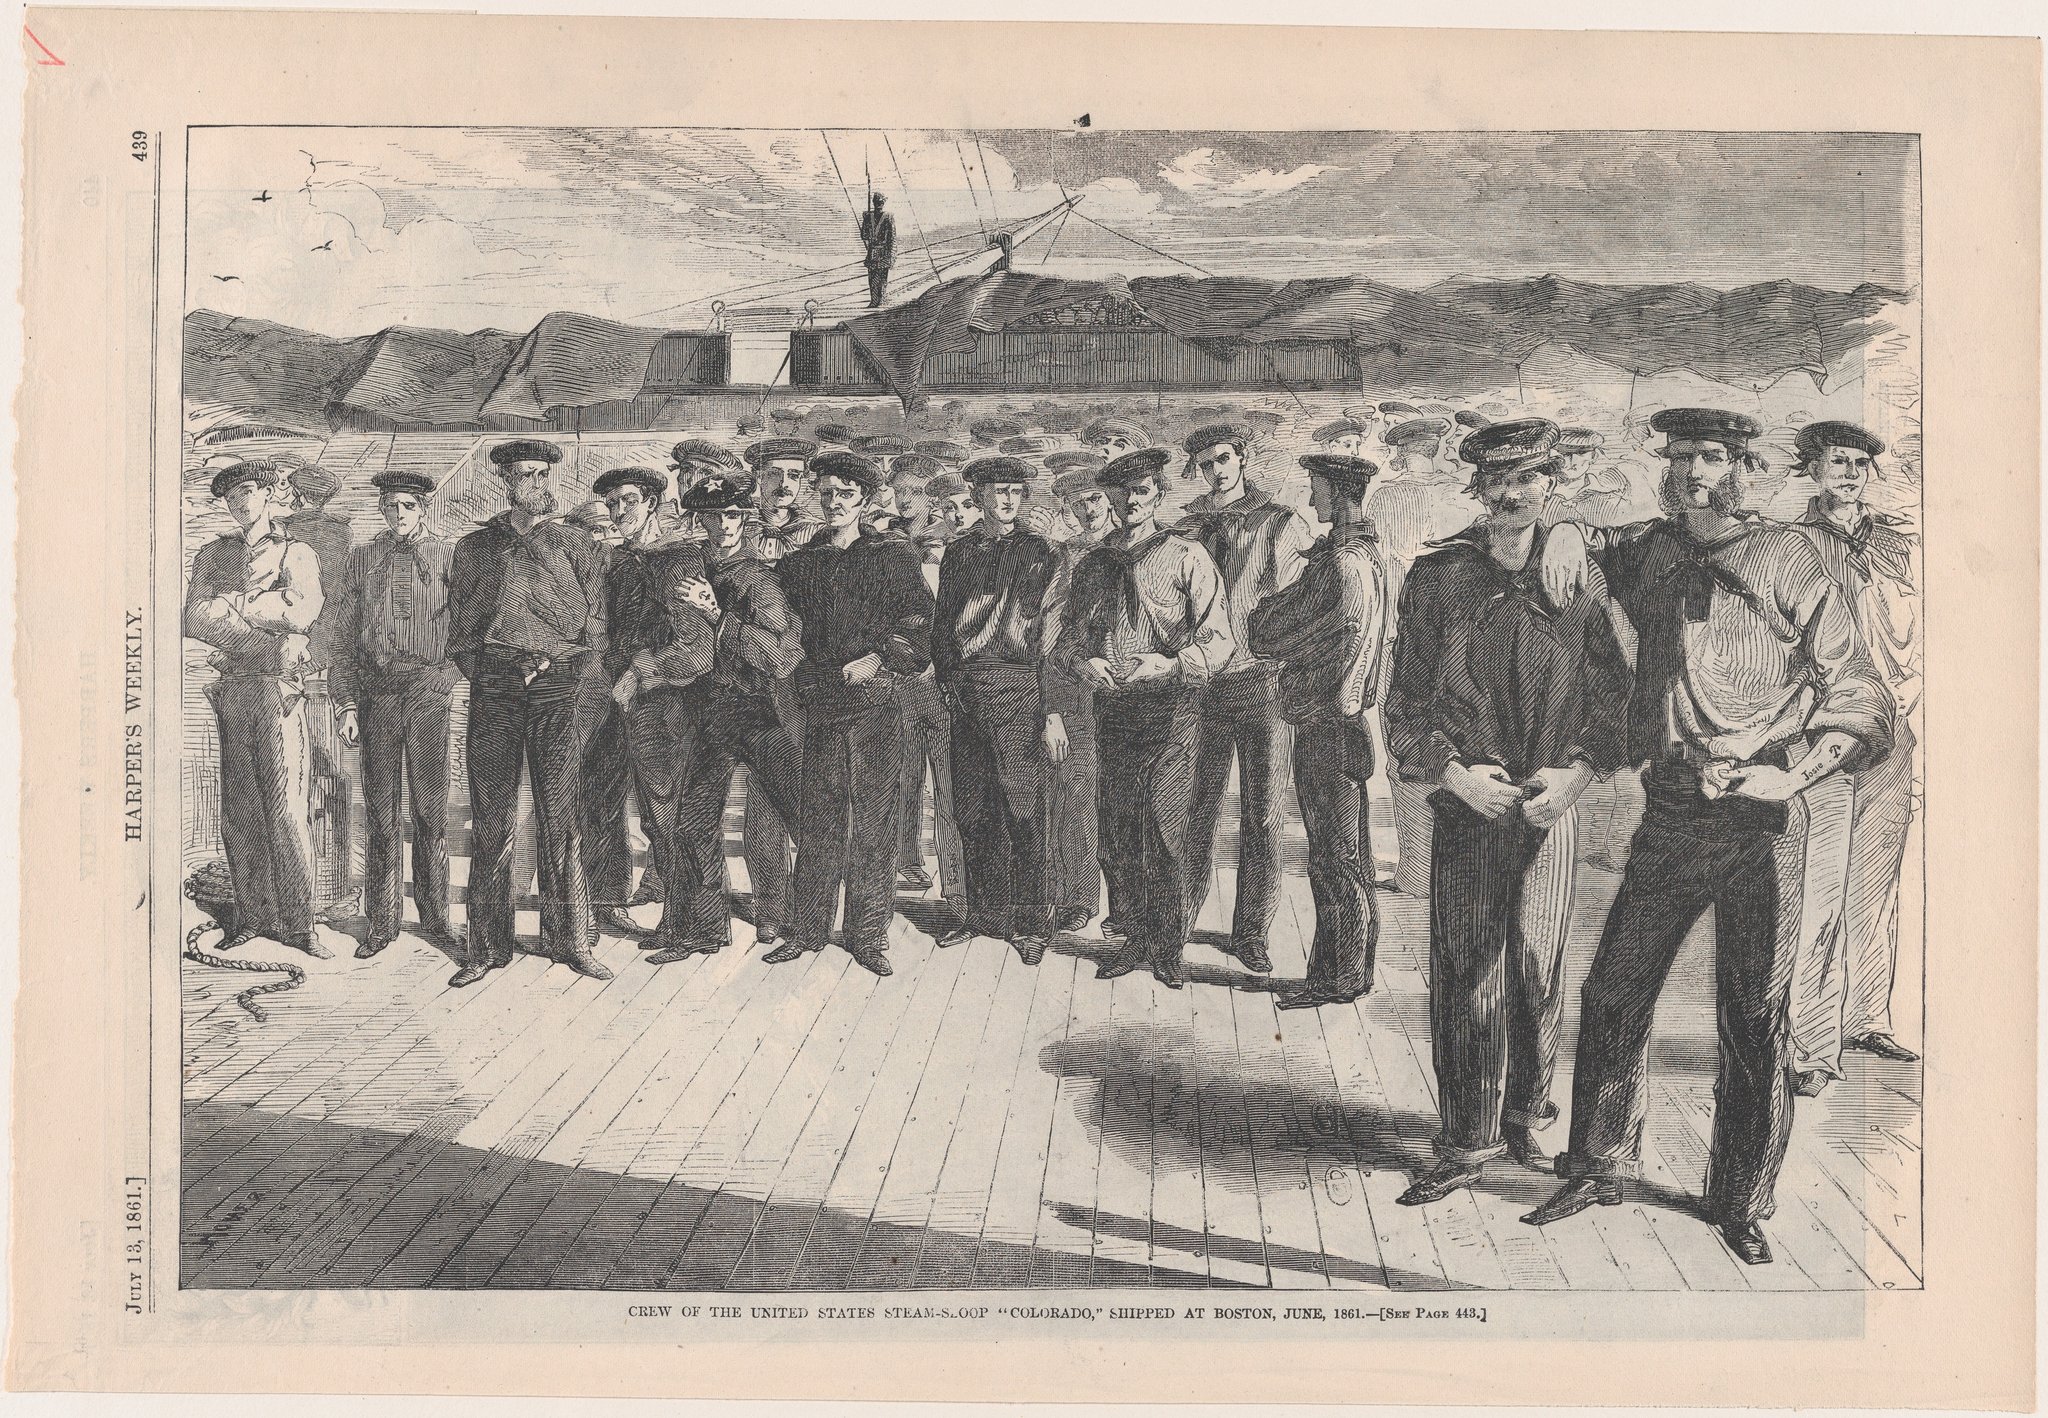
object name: print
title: Crew of U.S. Steamsloop "Colorado," Shipped at Boston, June 1861 (from "Harper's Weekly," Vol. 5, p. 439)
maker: winslow homer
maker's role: artist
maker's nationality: american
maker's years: 1836-1910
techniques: engraving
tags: american civil war,men,sailors